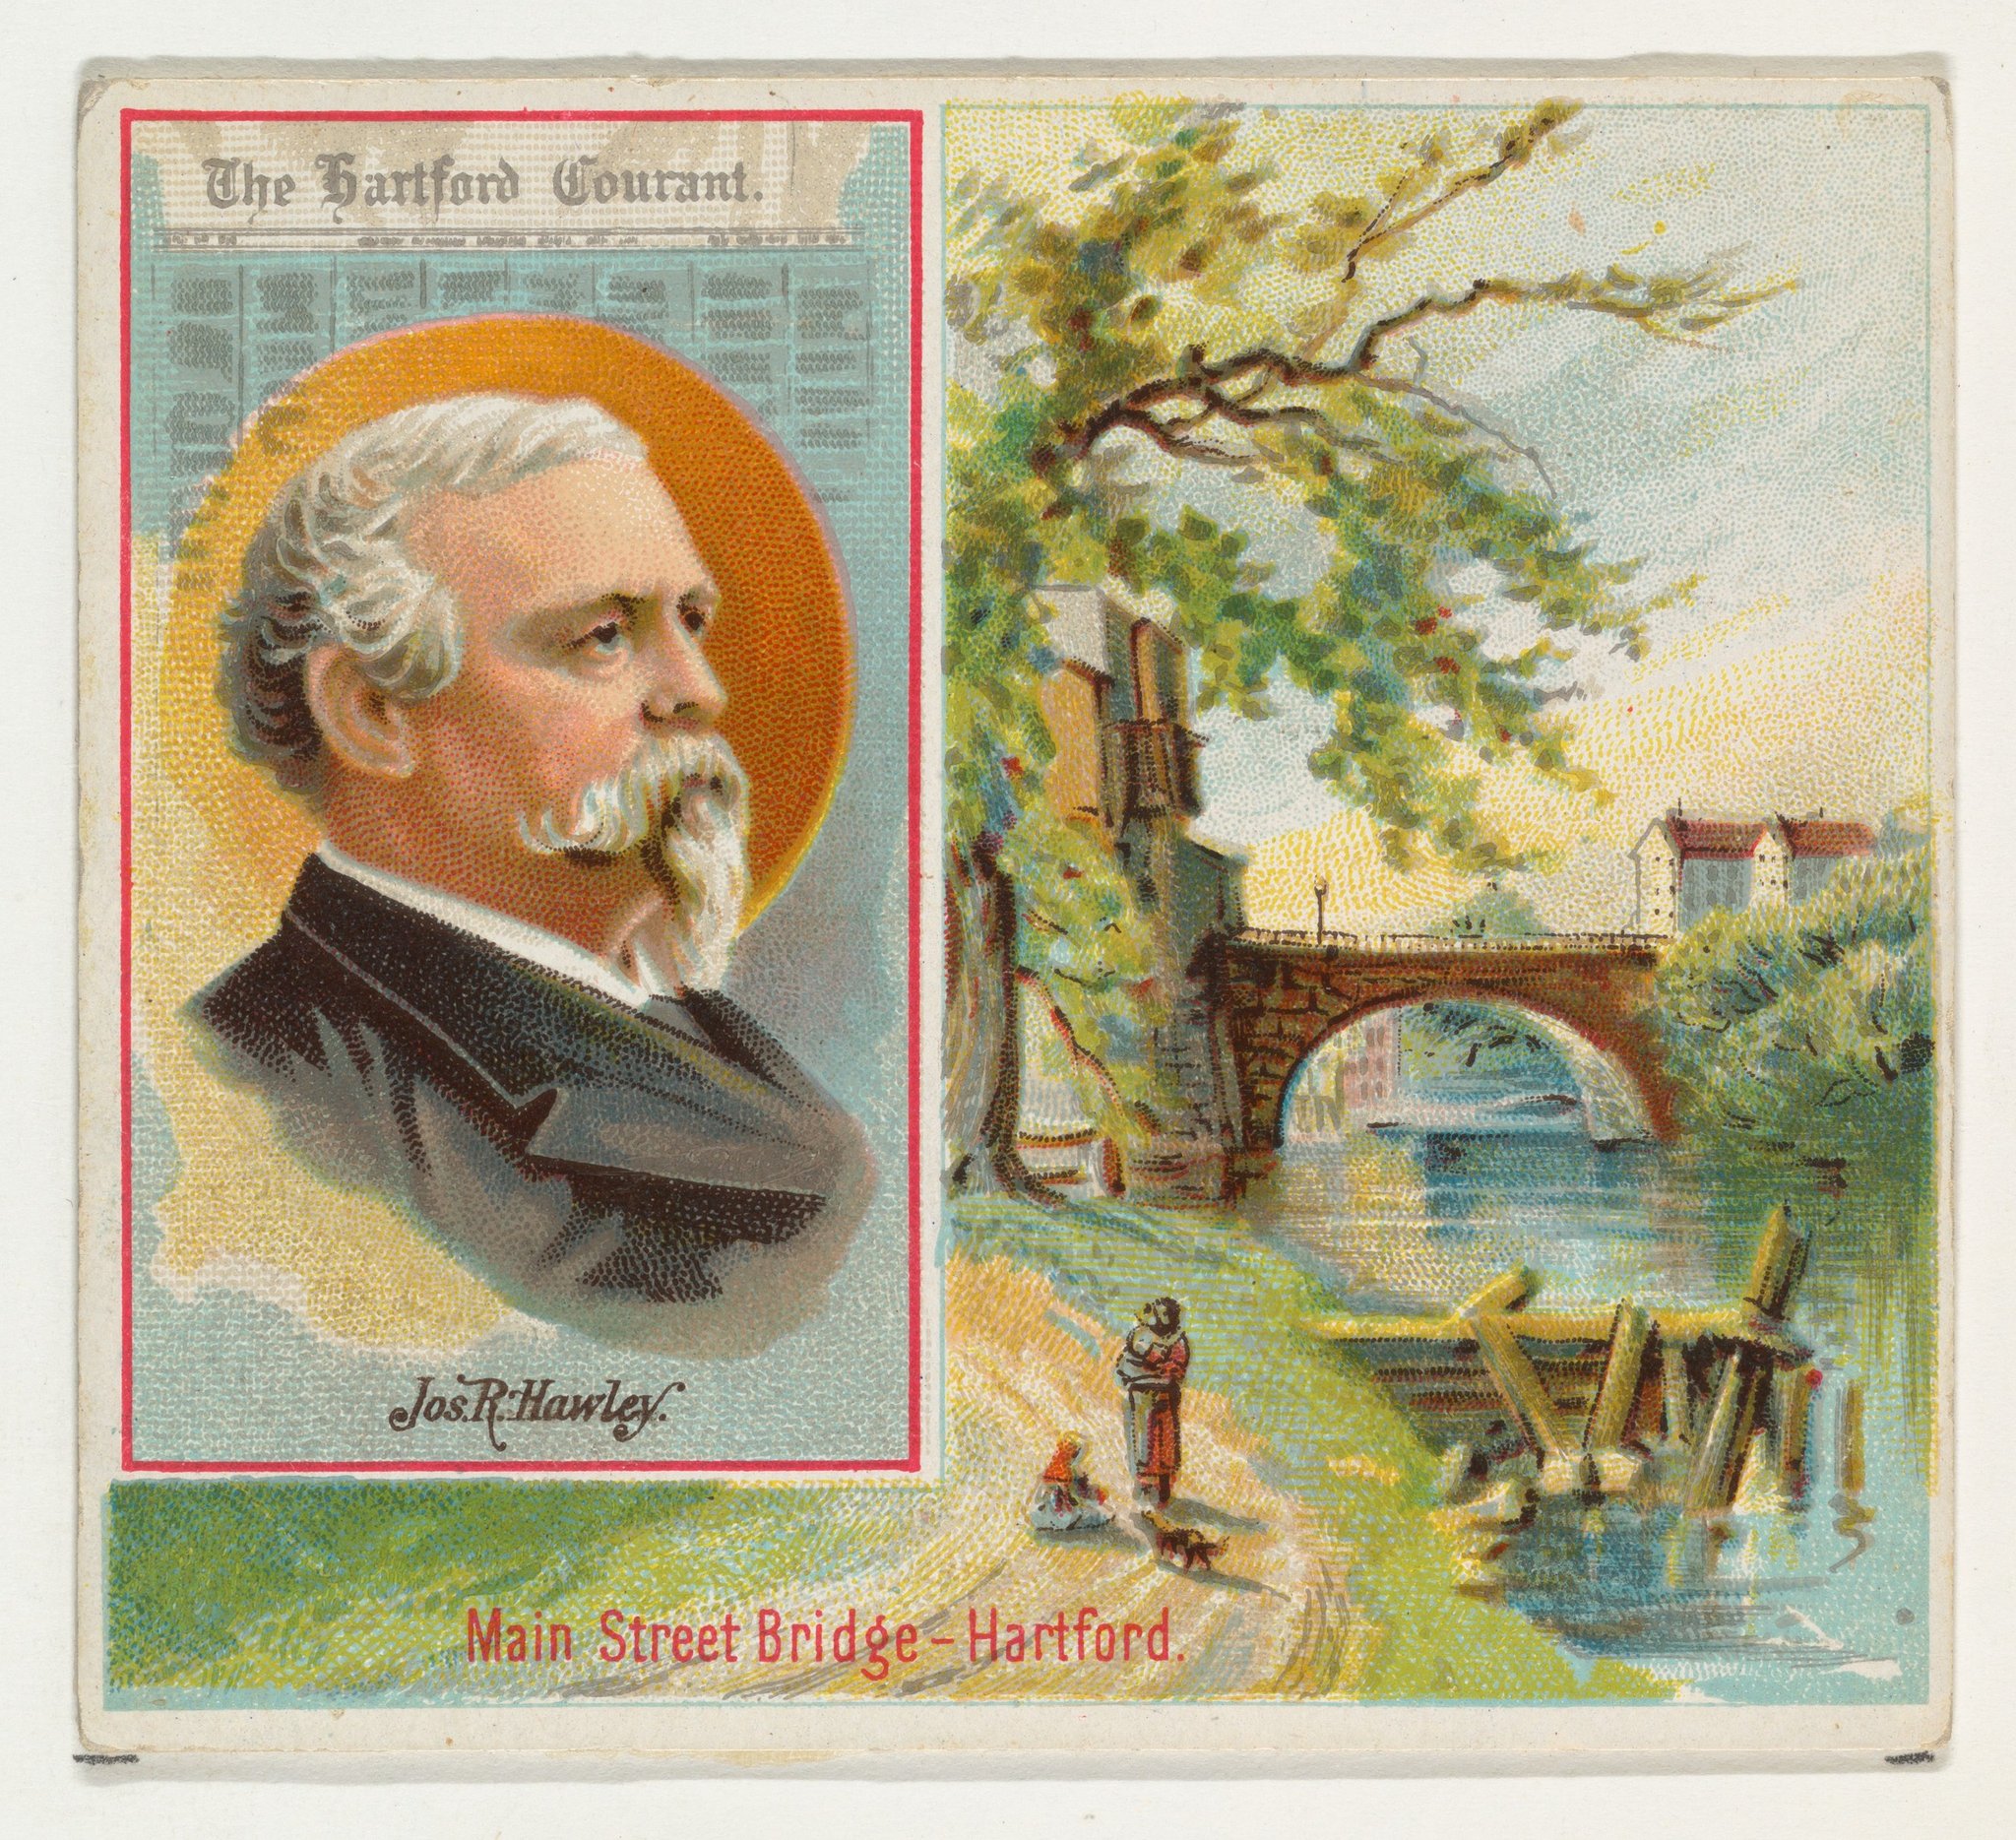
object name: print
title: Joseph R. Hawley, The Hartford Courant, from the American Editors series (N35) for Allen & Ginter Cigarettes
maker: allen & ginter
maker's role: publisher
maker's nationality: american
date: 1887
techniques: color lithograph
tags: bridges,men,profiles